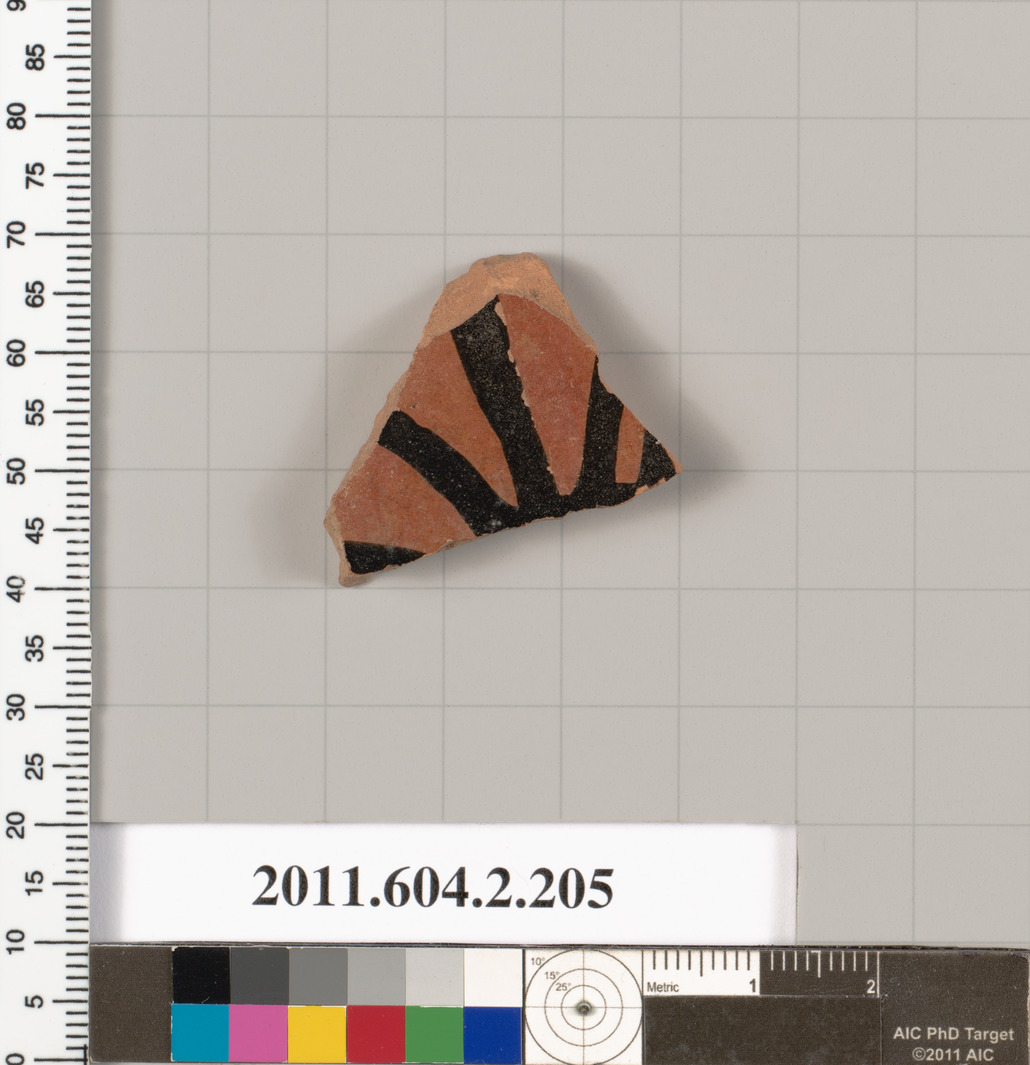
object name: stamnos fragment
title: Terracotta fragment of a stamnos (jar)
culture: greek, attic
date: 475-451 BCE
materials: terracotta